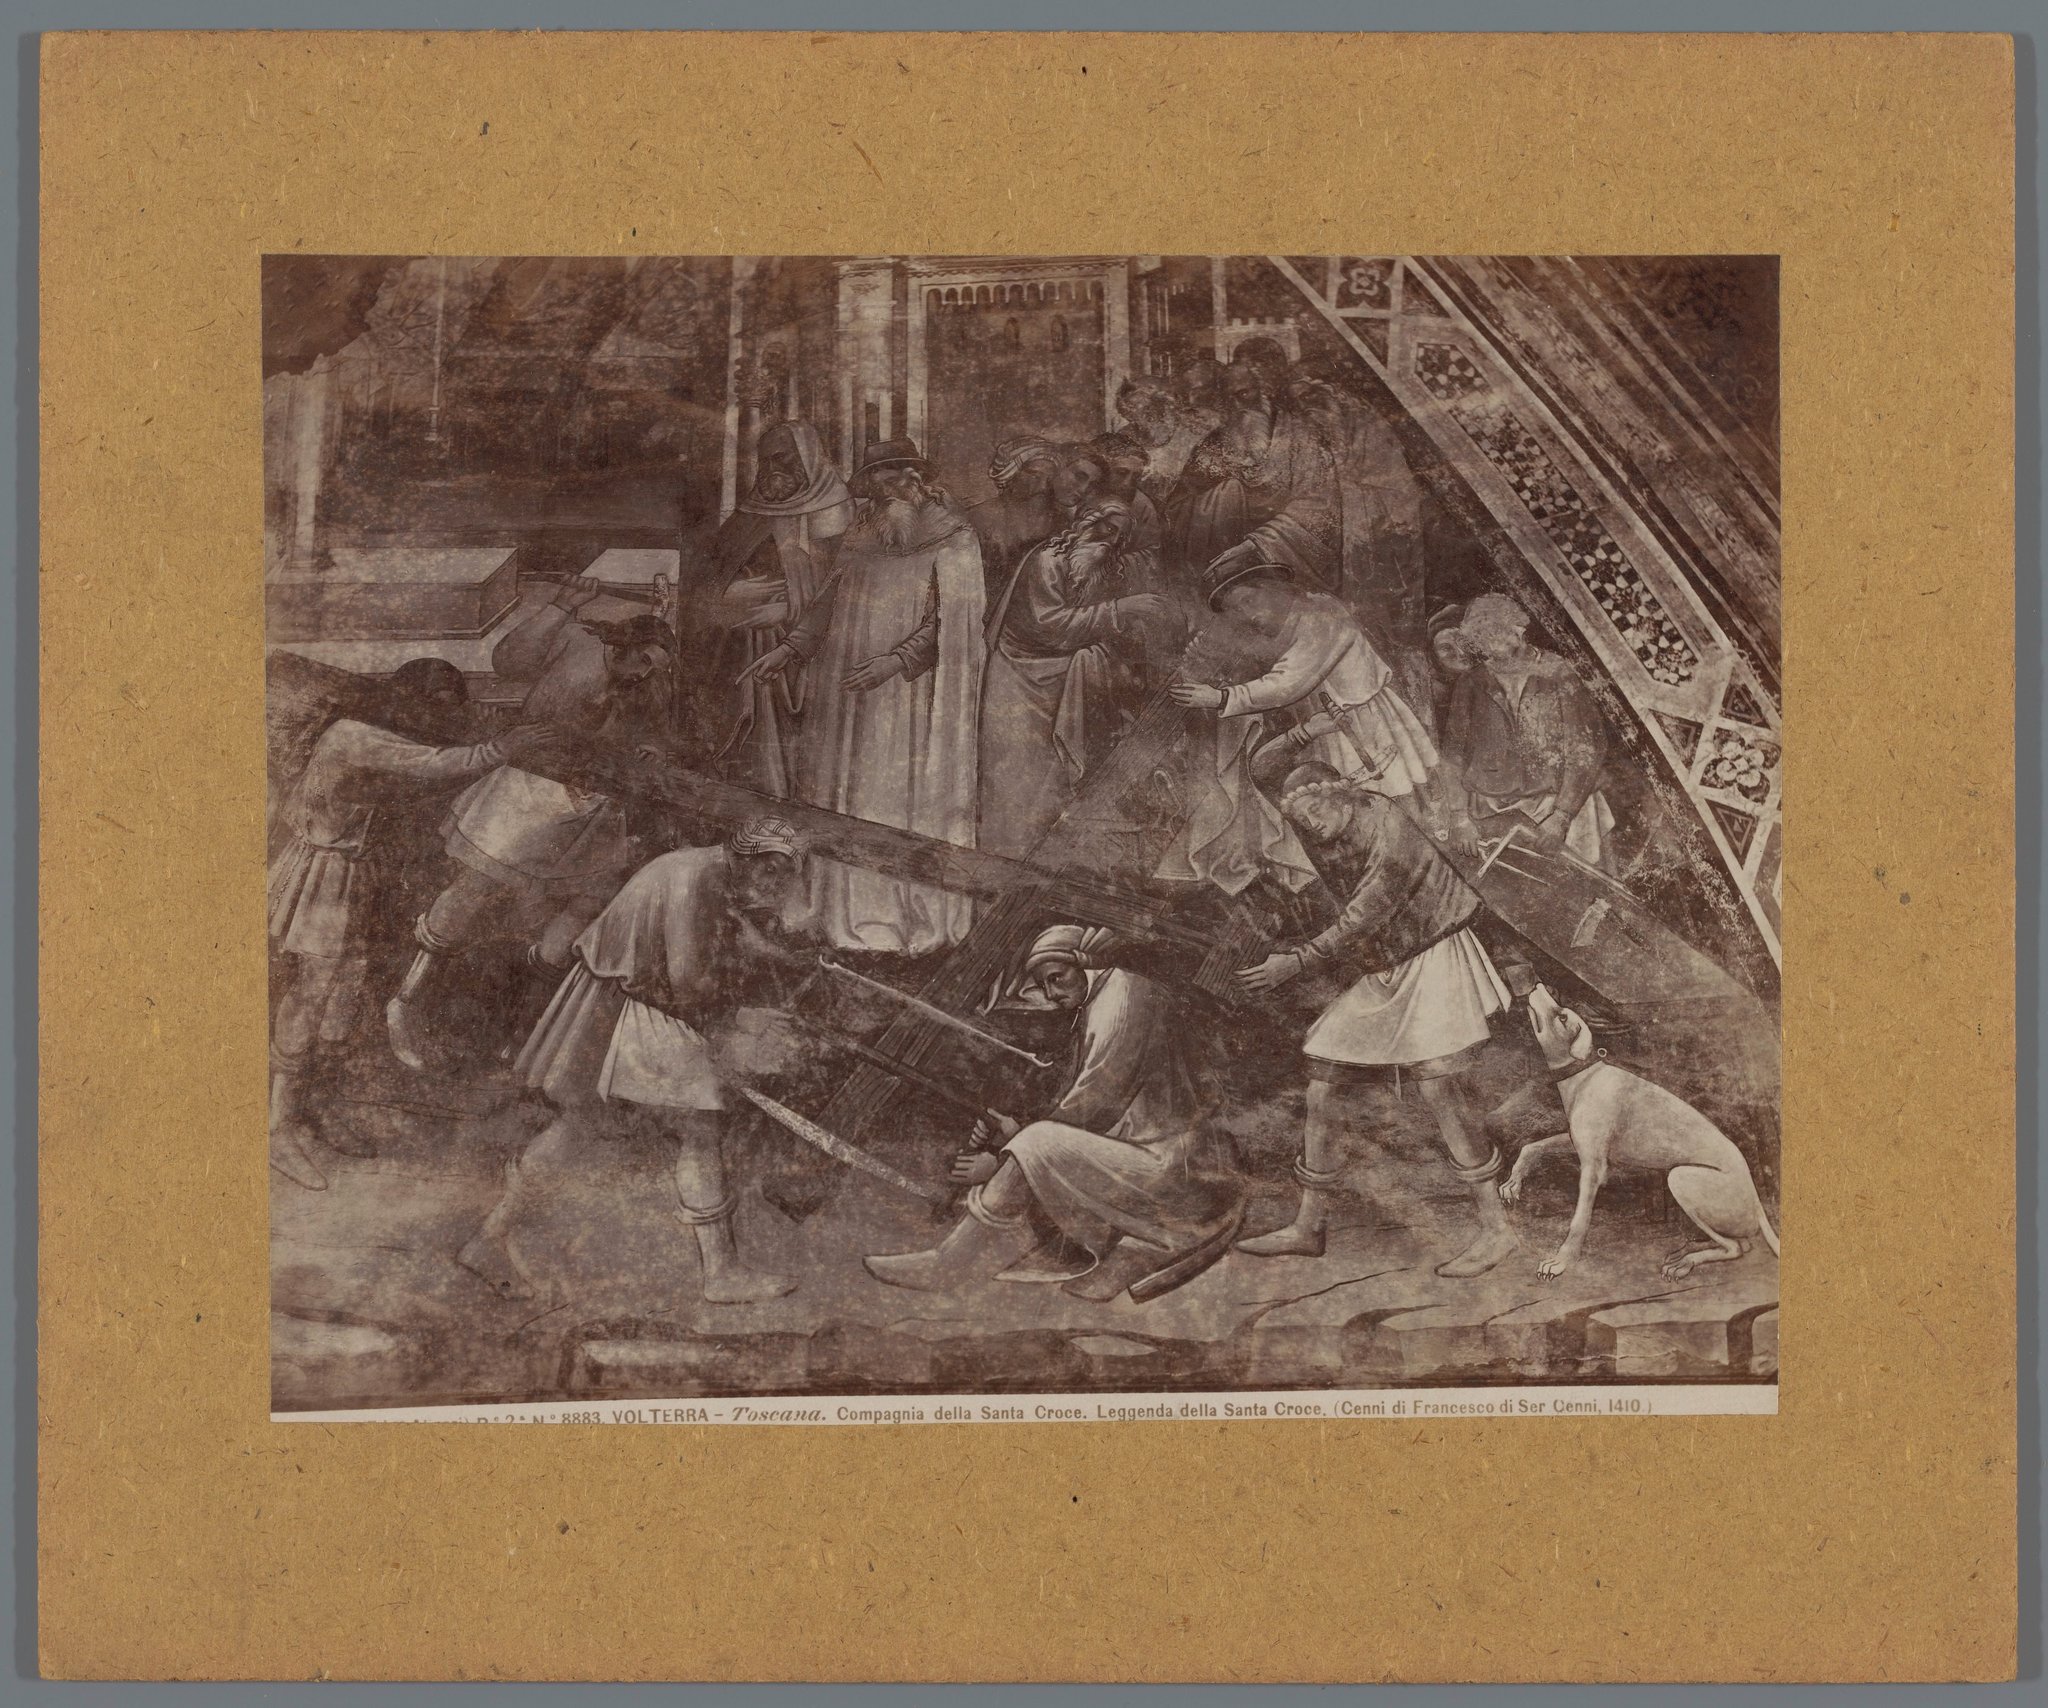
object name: photograph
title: Schildering door Cenni di Francesco in de Cappella della Croce di Giorno te Volterra, voorstellend de legende van het Heilige kruis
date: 1875-1900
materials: cardboard, photographic support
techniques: albumen print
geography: chiesa di san francesco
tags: painting (including book-illumination, miniature-painting) (+ plaster ~ arts), 11d4114 the wood is taken from the pool of bethesda to serve as christ's cross ~ legend of the true cross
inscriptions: collector's mark: Lugt 3937, number: ‘N.o 8883.’